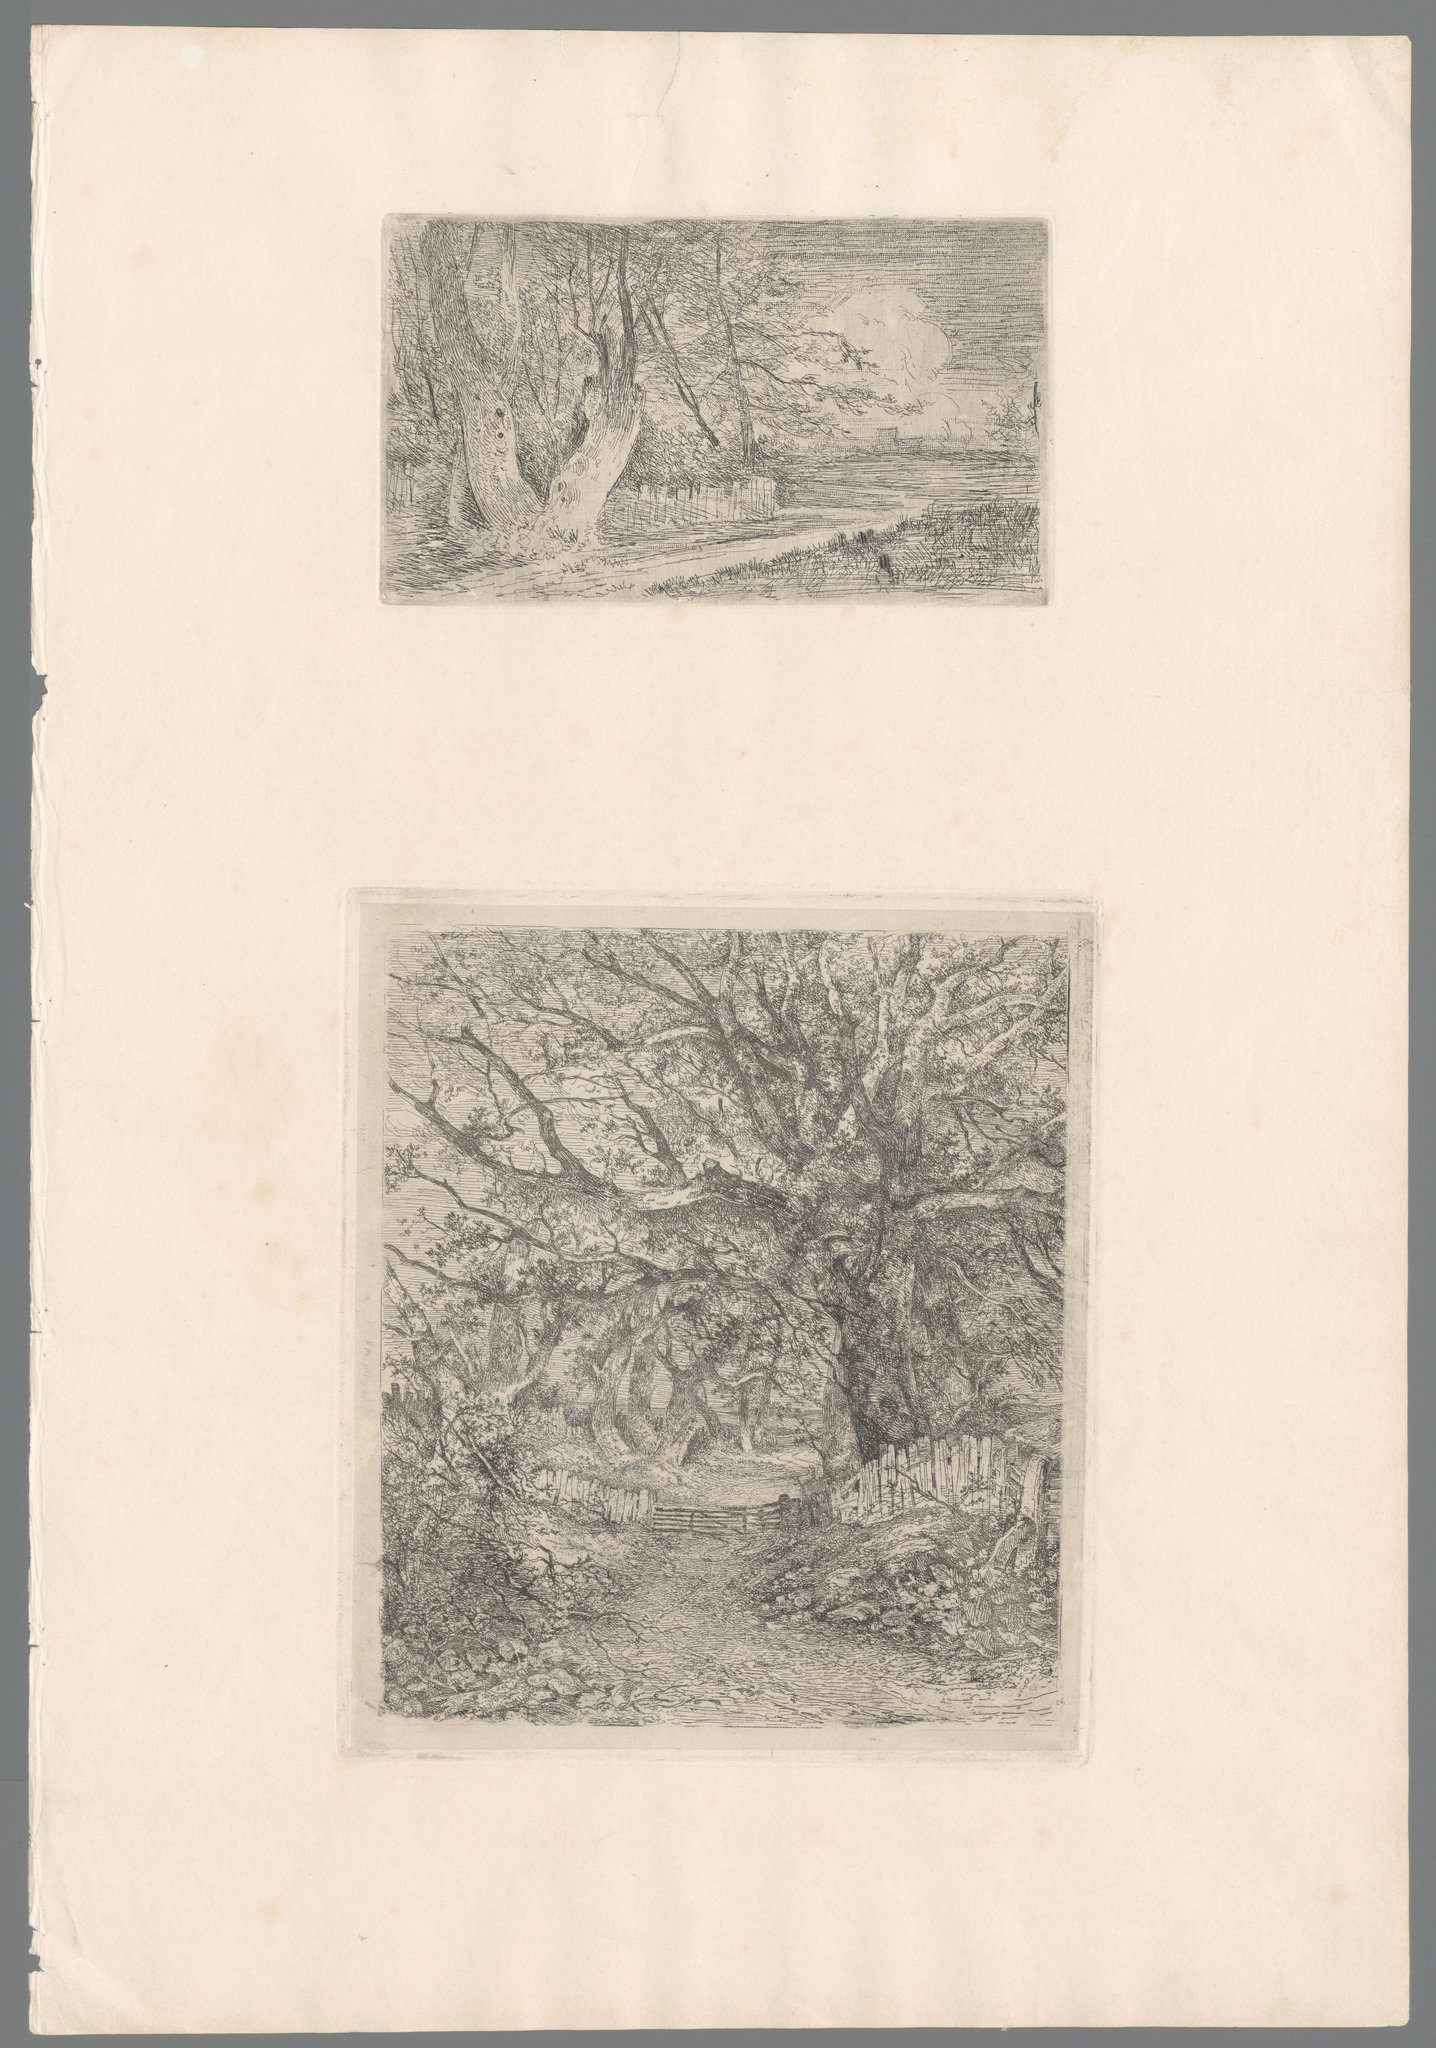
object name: print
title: Pad langs een boom en houten hek, rechts een open veld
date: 1834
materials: paper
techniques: drypoint, etching, intaglio, roulette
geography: norwich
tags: fence, wall, paling, road, path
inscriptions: collector's mark: Lugt 2228, collector's mark: Lugt 2760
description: Prent staat samen met RP-P-1973-181 op een onversneden blad. Goldberg noemt in zijn catalogus twee staten. Theobald denkt echter dat de kwaliteit van de afdruk het verschil tussen de twee verschillende 'staten', in dat geval dus één staat, verklaart, waarbij in de tweede 'staat' van Goldberg alleen meer plaattoon aanwezig is.